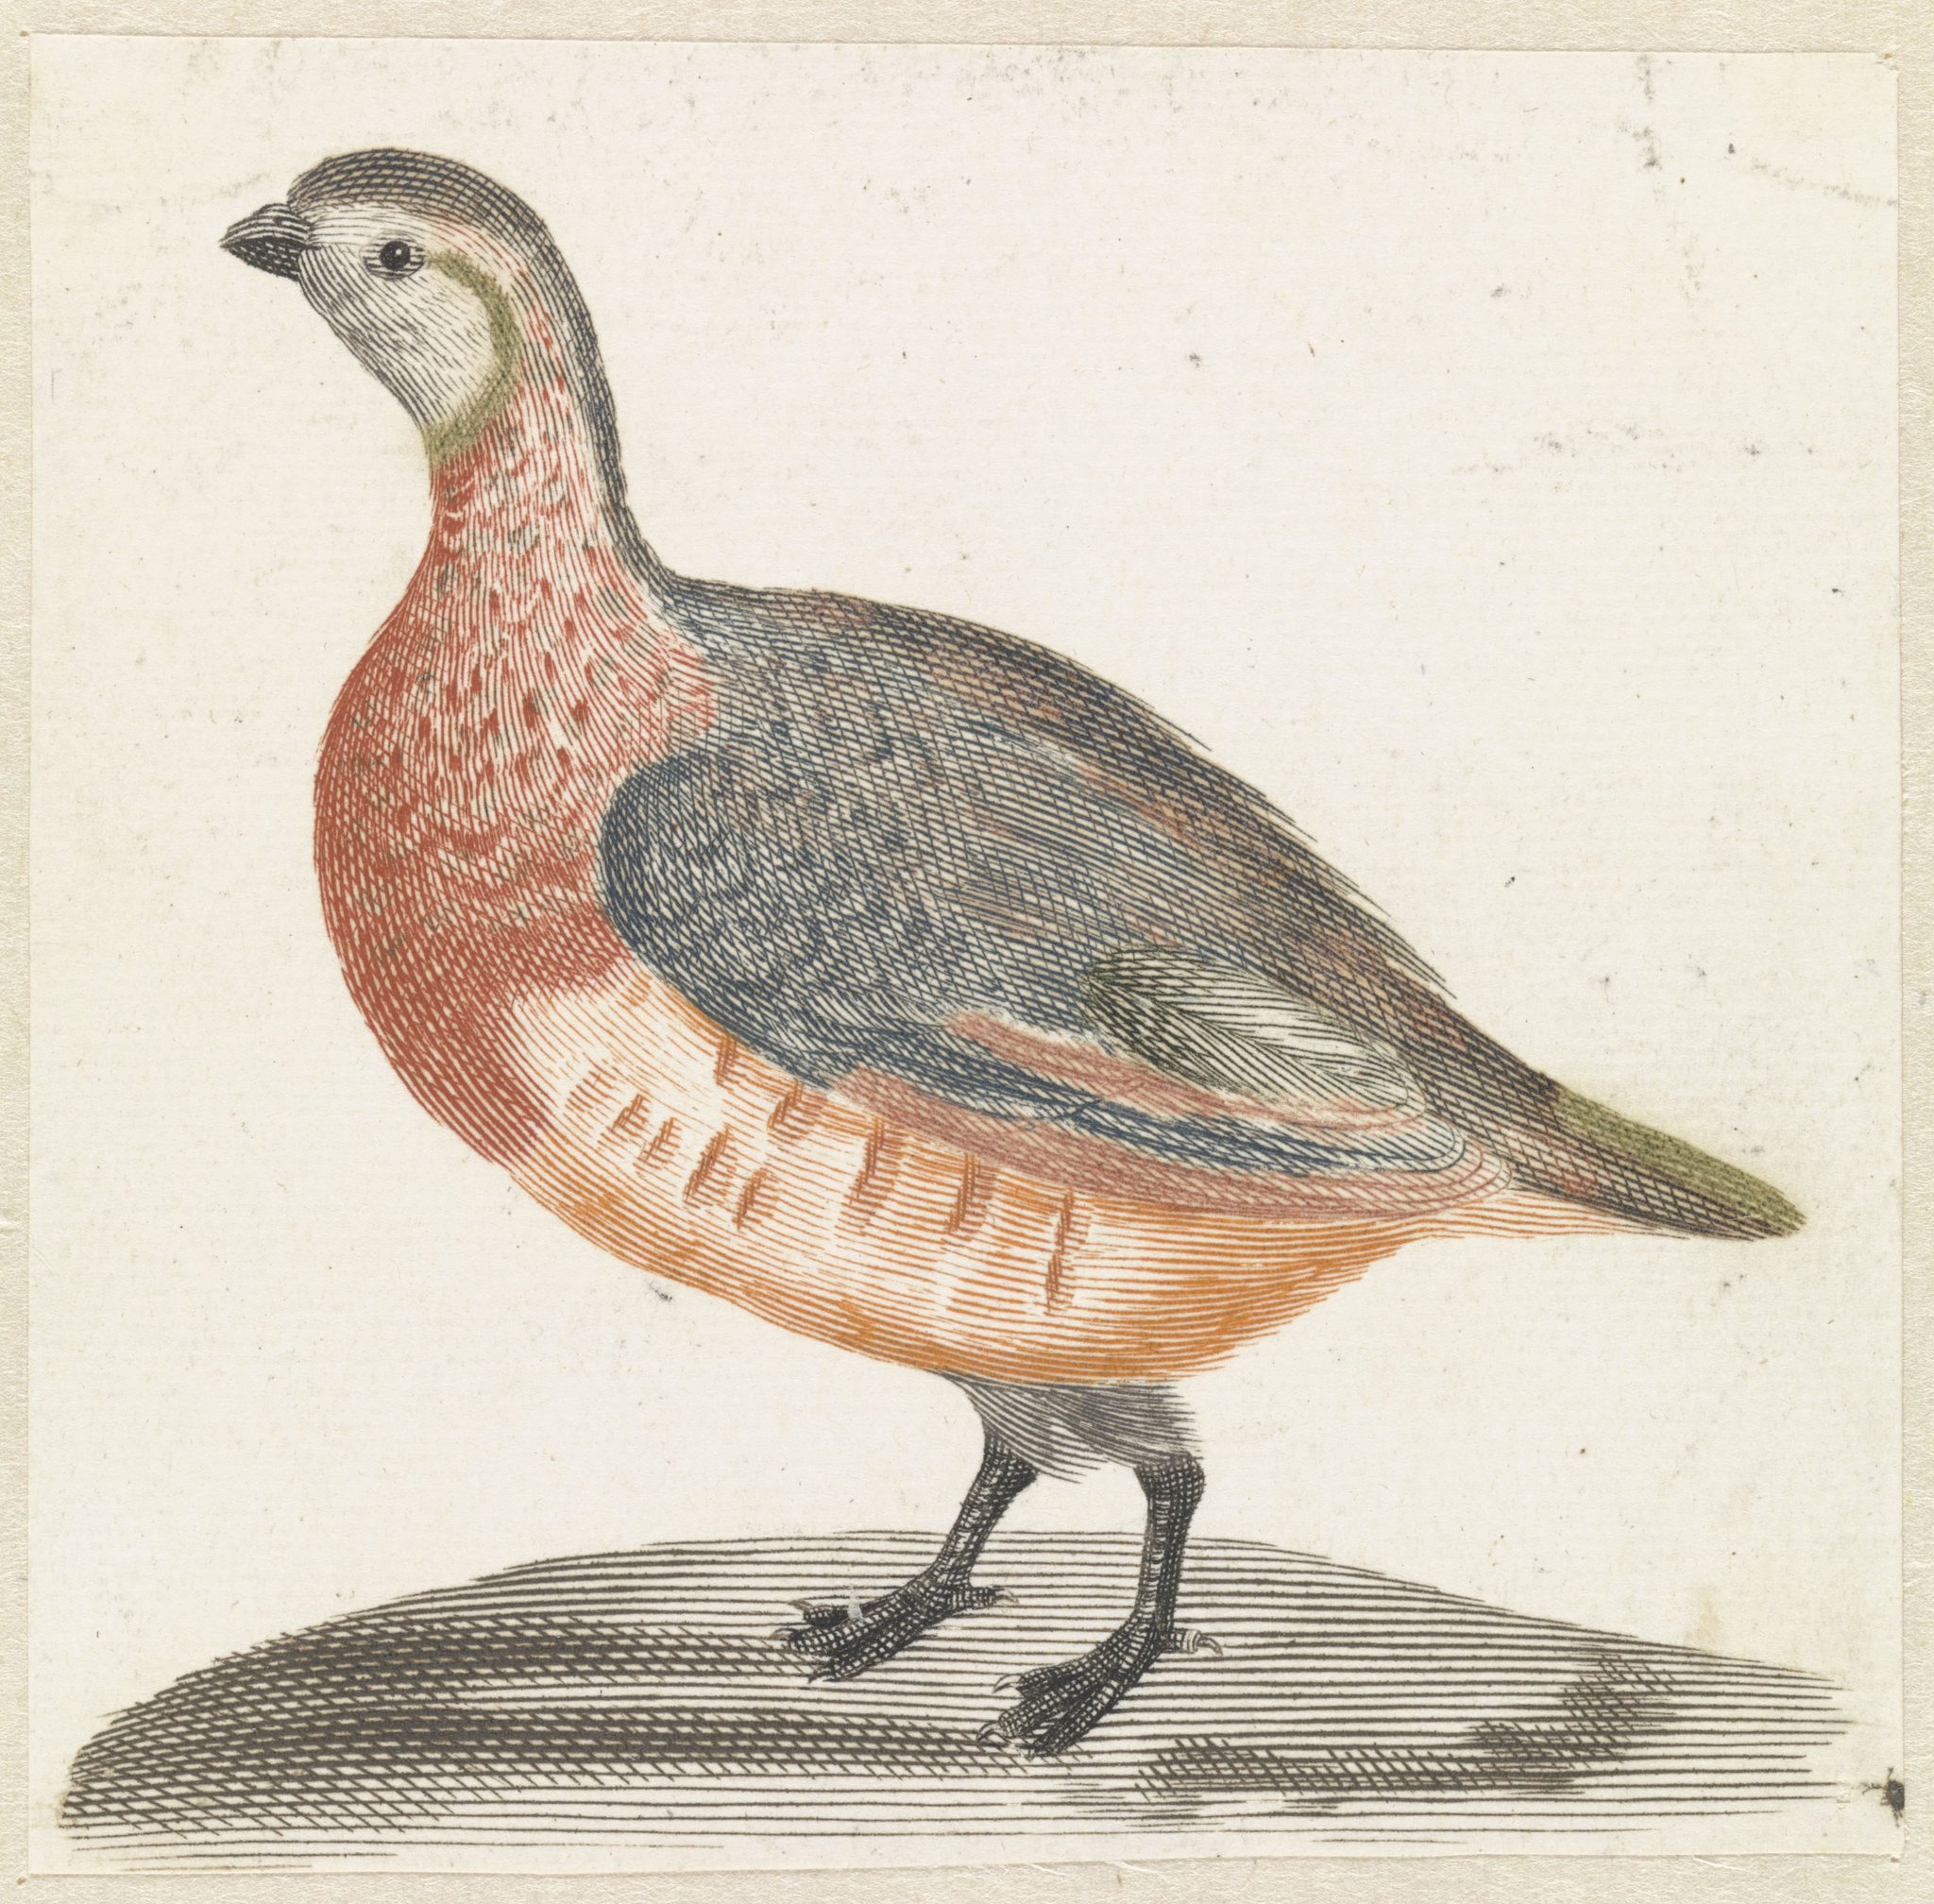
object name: print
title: Veldhoen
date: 1688-1698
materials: paper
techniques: printing, engraving, lithography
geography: netherlands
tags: walker and runner birds: partridge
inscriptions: collector's mark: Lugt 2228